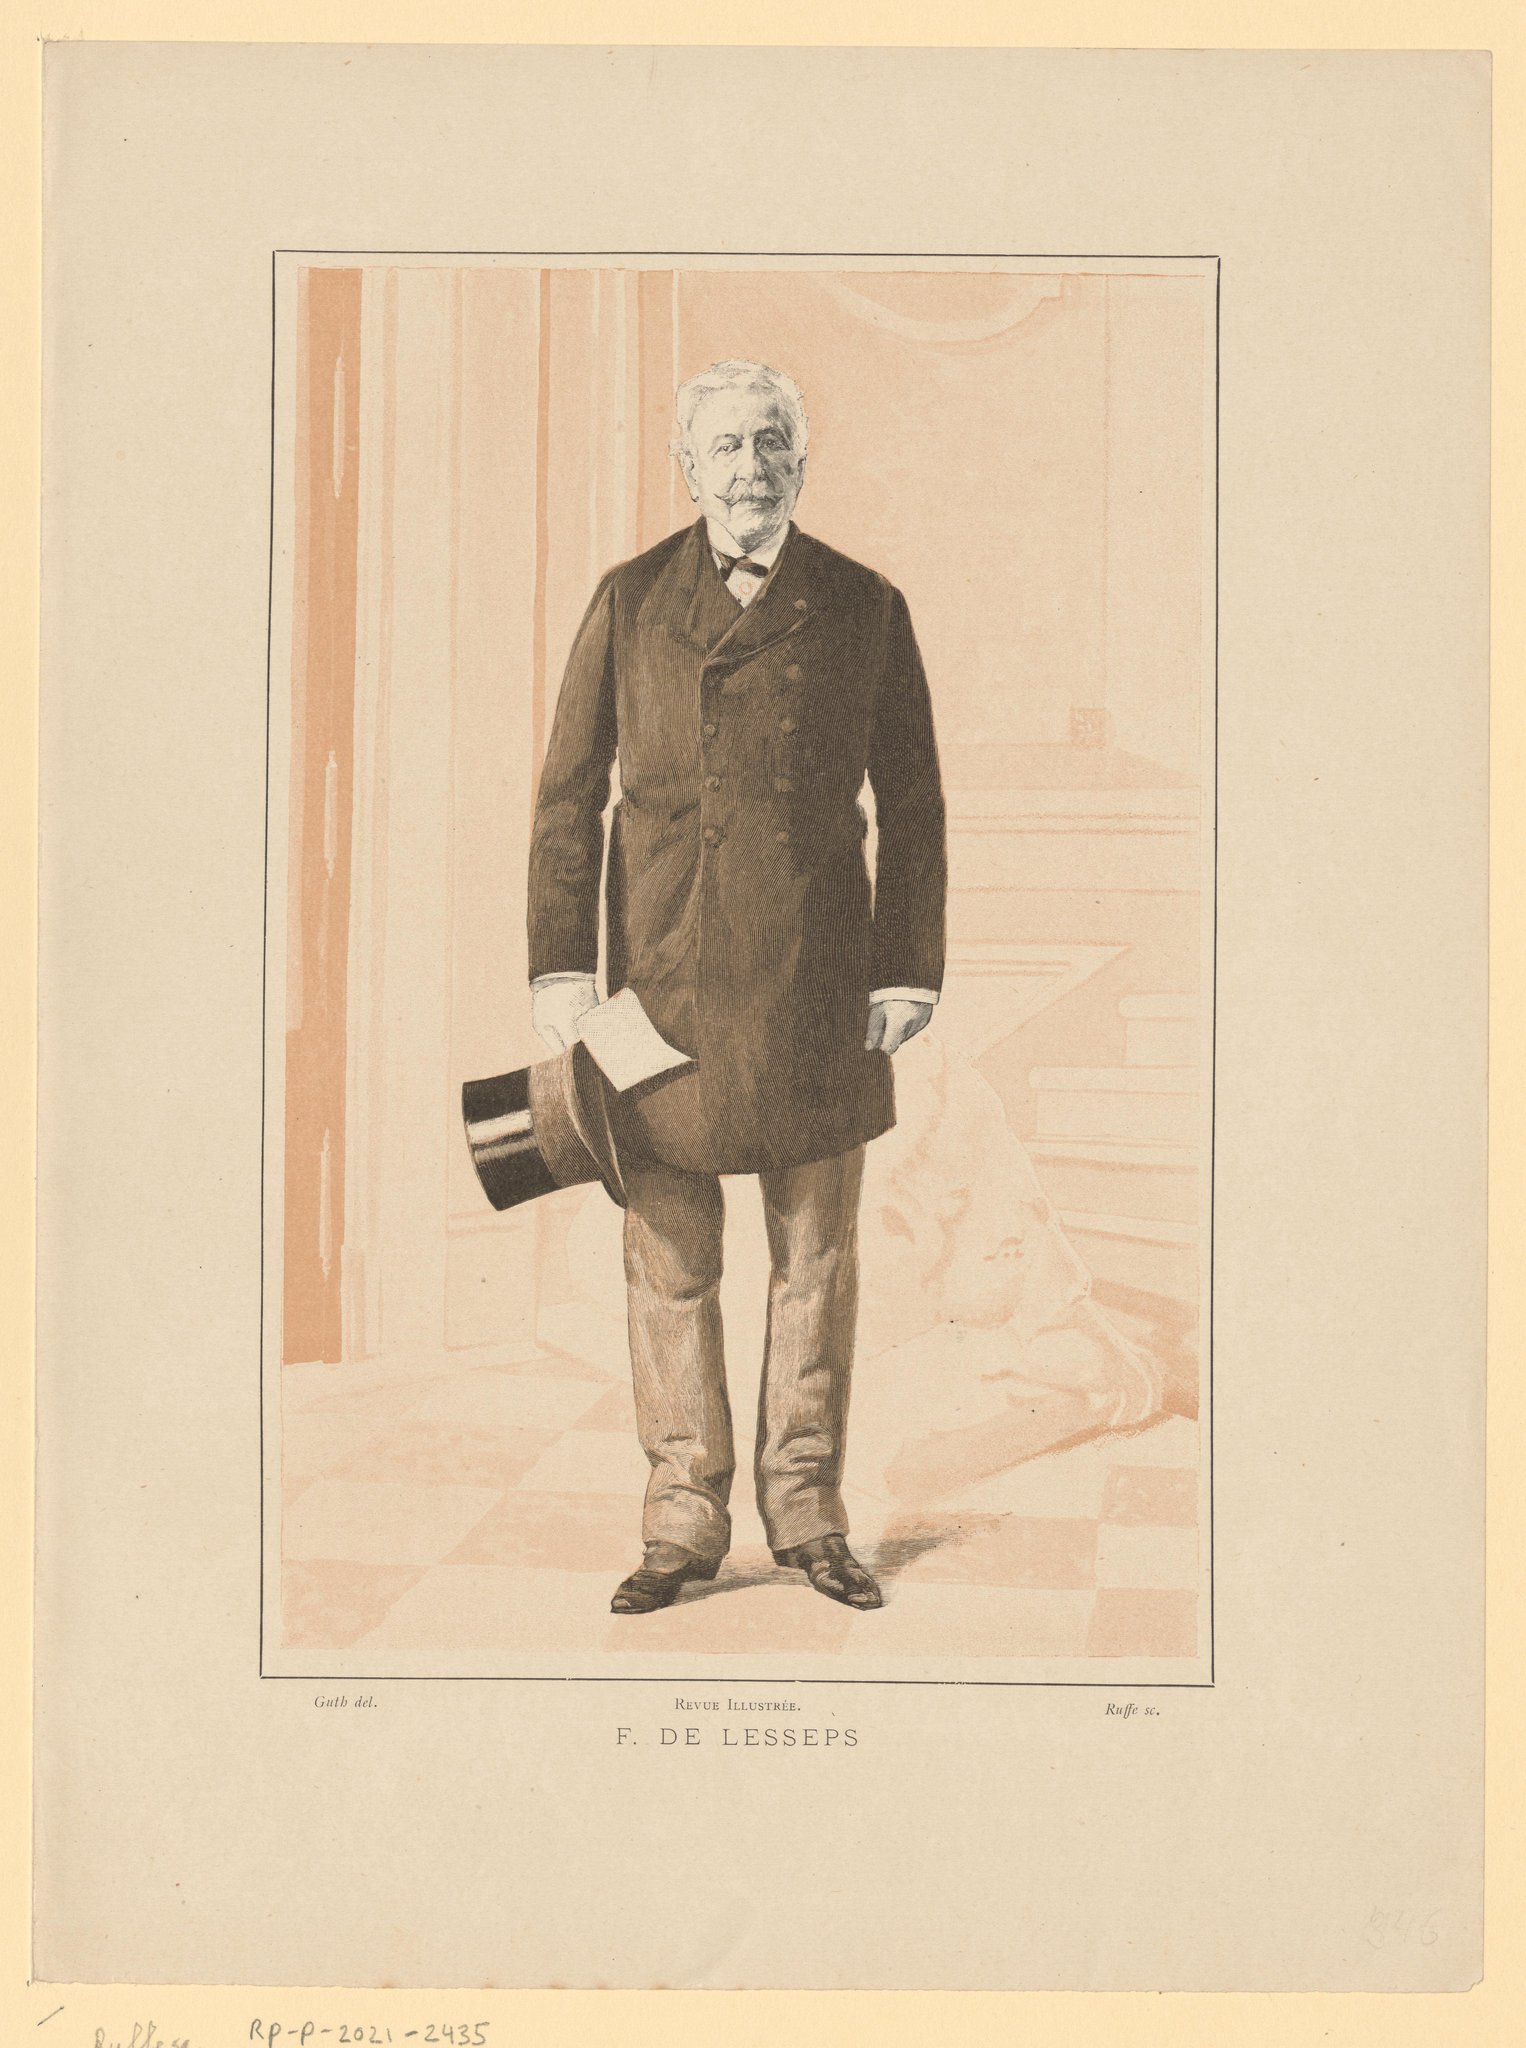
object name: print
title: Portret van Ferdinand de Lesseps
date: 1886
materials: paper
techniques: engraving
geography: paris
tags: france, engineer, engineering (+ portrait of scholar, scientist), historical persons, head-gear: hat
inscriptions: inscription: ‘Ag 67/ 13’, inscription: ‘AA 42/ 22’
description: Prent waarschijnlijk uit: Revue Illustré (1886), nr. 6.